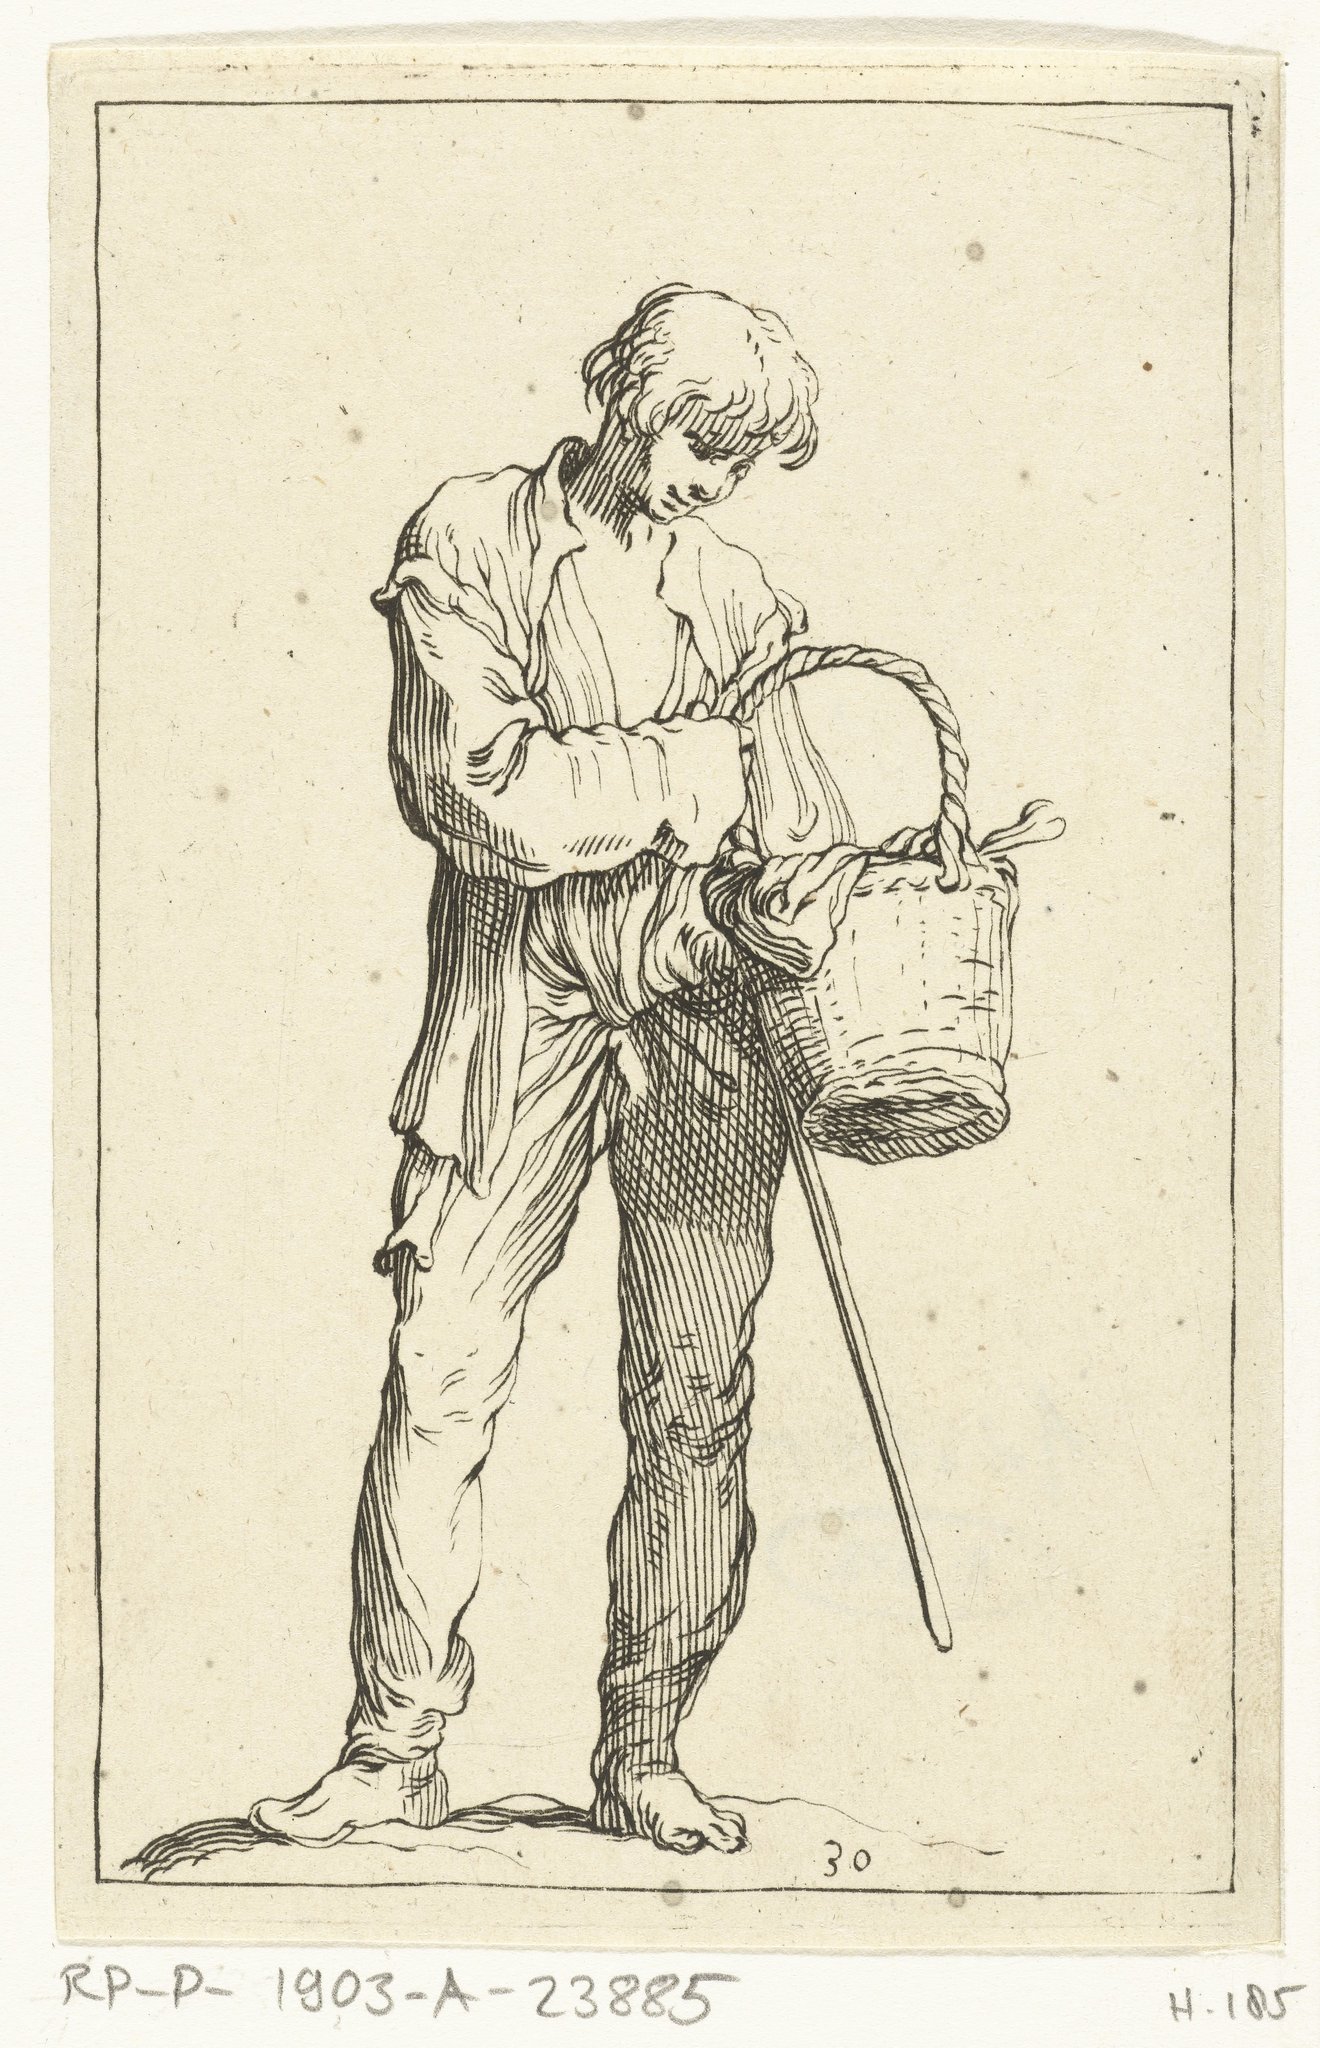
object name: print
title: De kleine figuren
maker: frederick bloemaert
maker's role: print maker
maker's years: 1614-1669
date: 1635-1669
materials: paper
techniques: engraving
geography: utrecht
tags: farmers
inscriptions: collector's mark: Lugt 2228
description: Jongeman met stok die met de linkerhand iets uit een mand haalt.